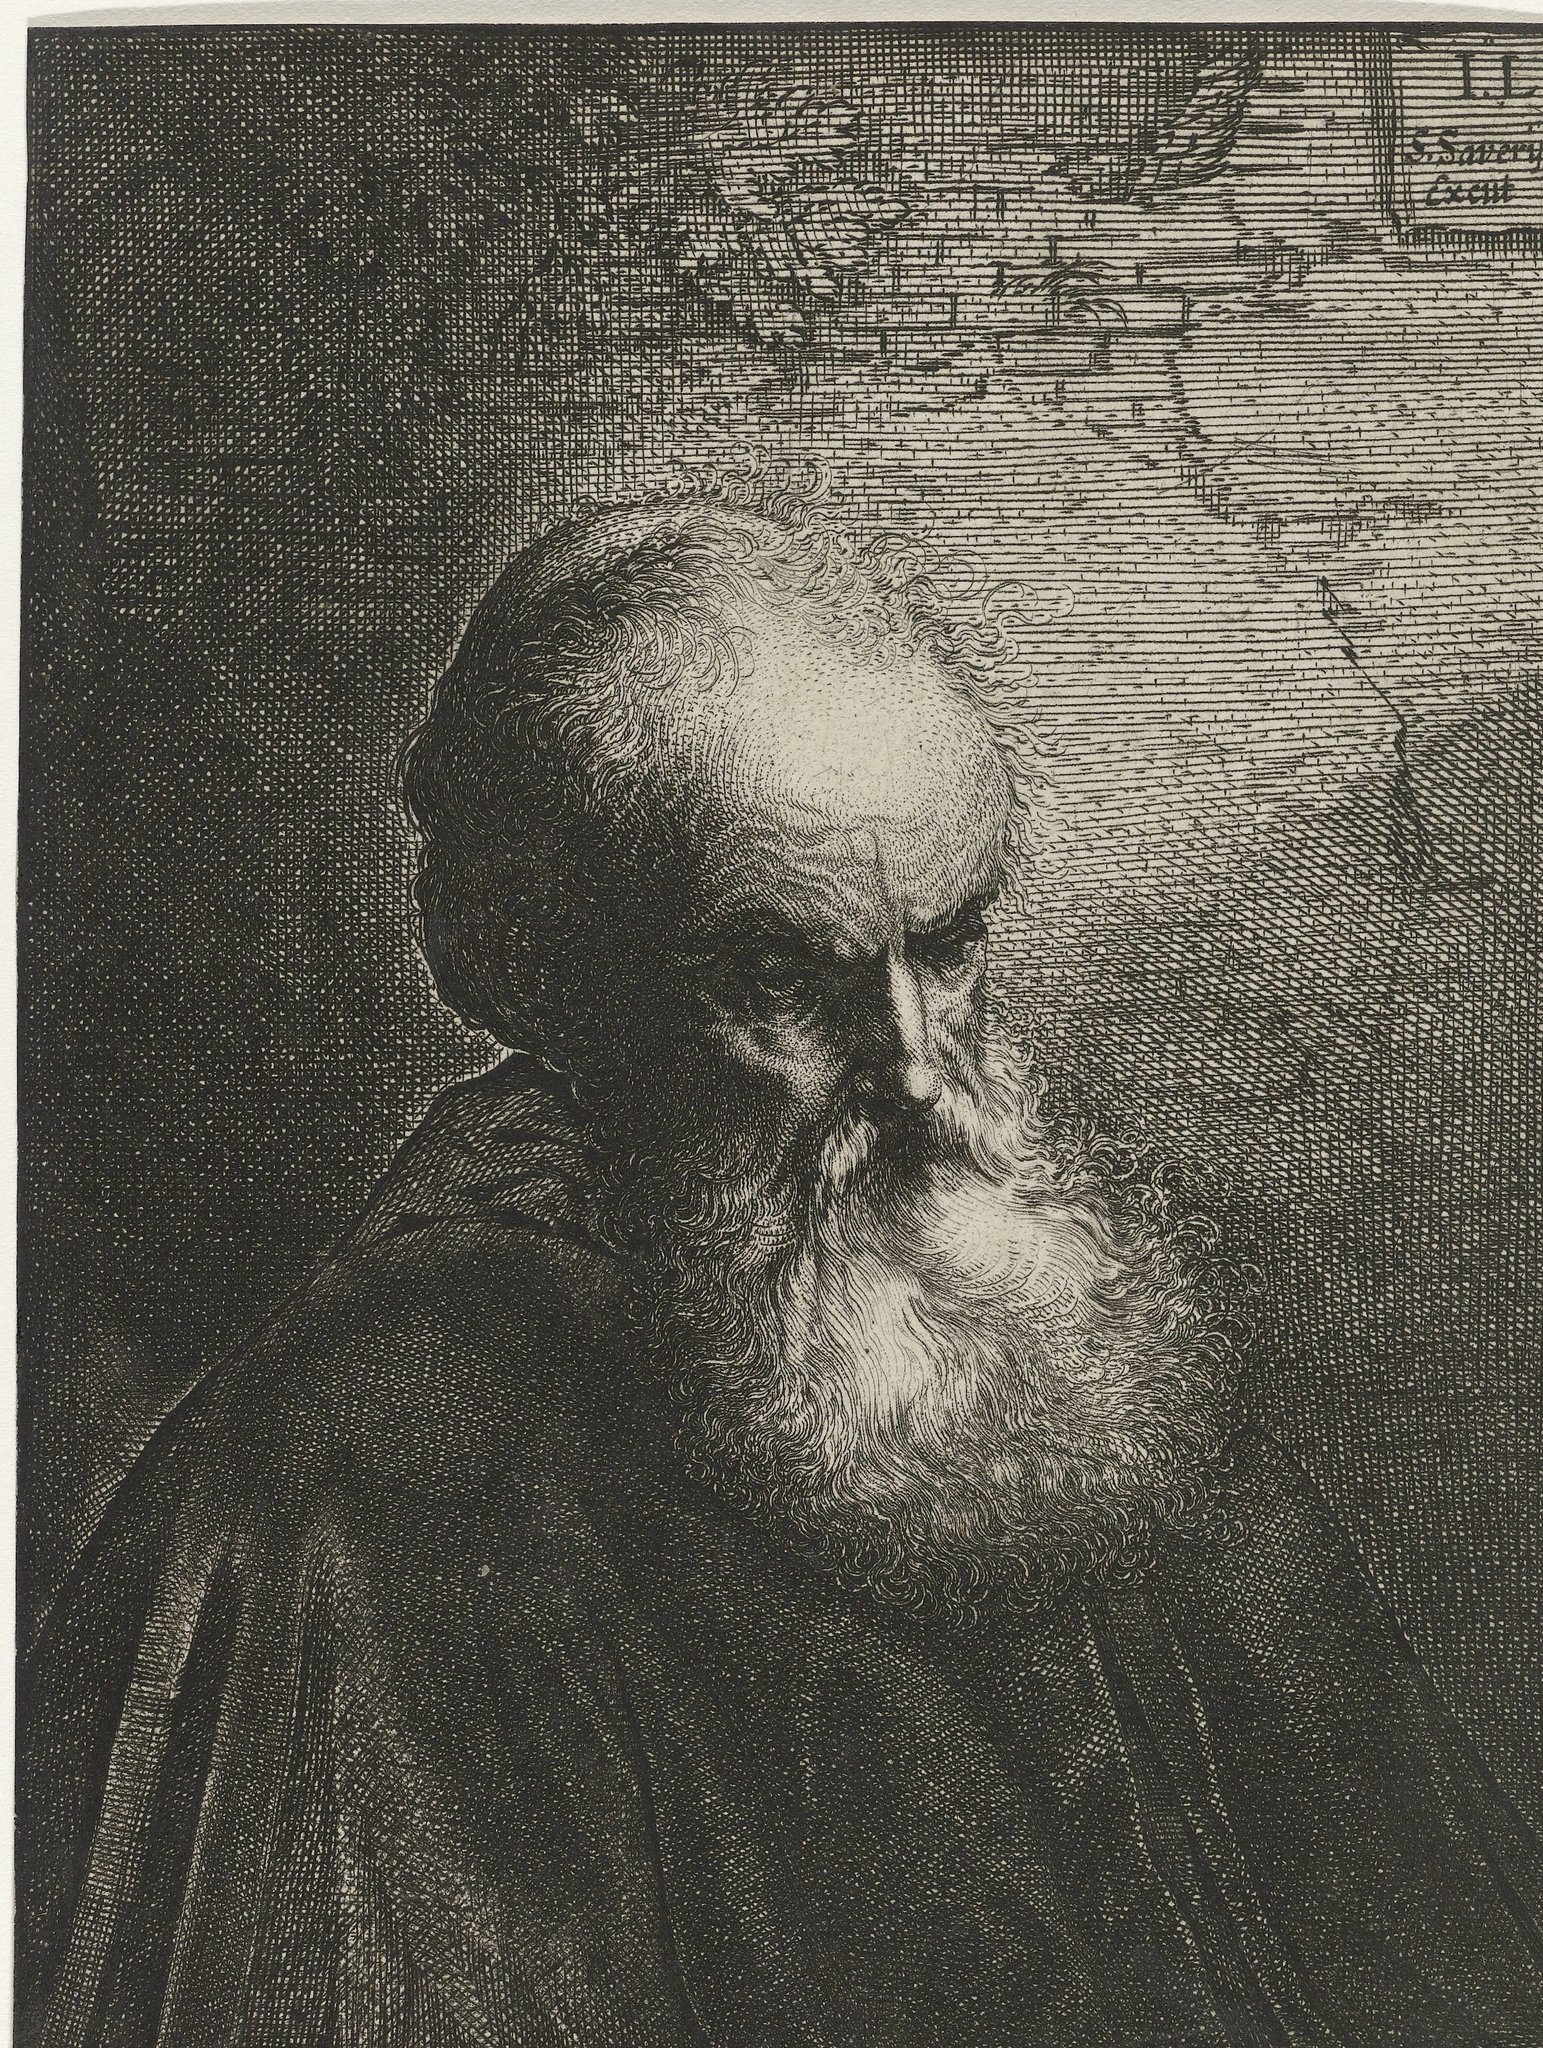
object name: print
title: Portret van een oude man met baard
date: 1617-1665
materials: paper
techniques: engraving, etching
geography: amsterdam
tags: old man, beard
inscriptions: collector's mark: Lugt 240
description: Portret tevens gebruikt in: Schabaelje, Jan Philipsz. Den grooten emblemata sacra, bestaande in meer dan drie hondert bybelsche figueren, soo des Ouden als des Nieuwen Testaments. Amsterdam: Tymon Houthaeck en Jan Philipsz Schabaelje, 1654. De oude man fungeert hierin als de oudtestamentische Jakob.